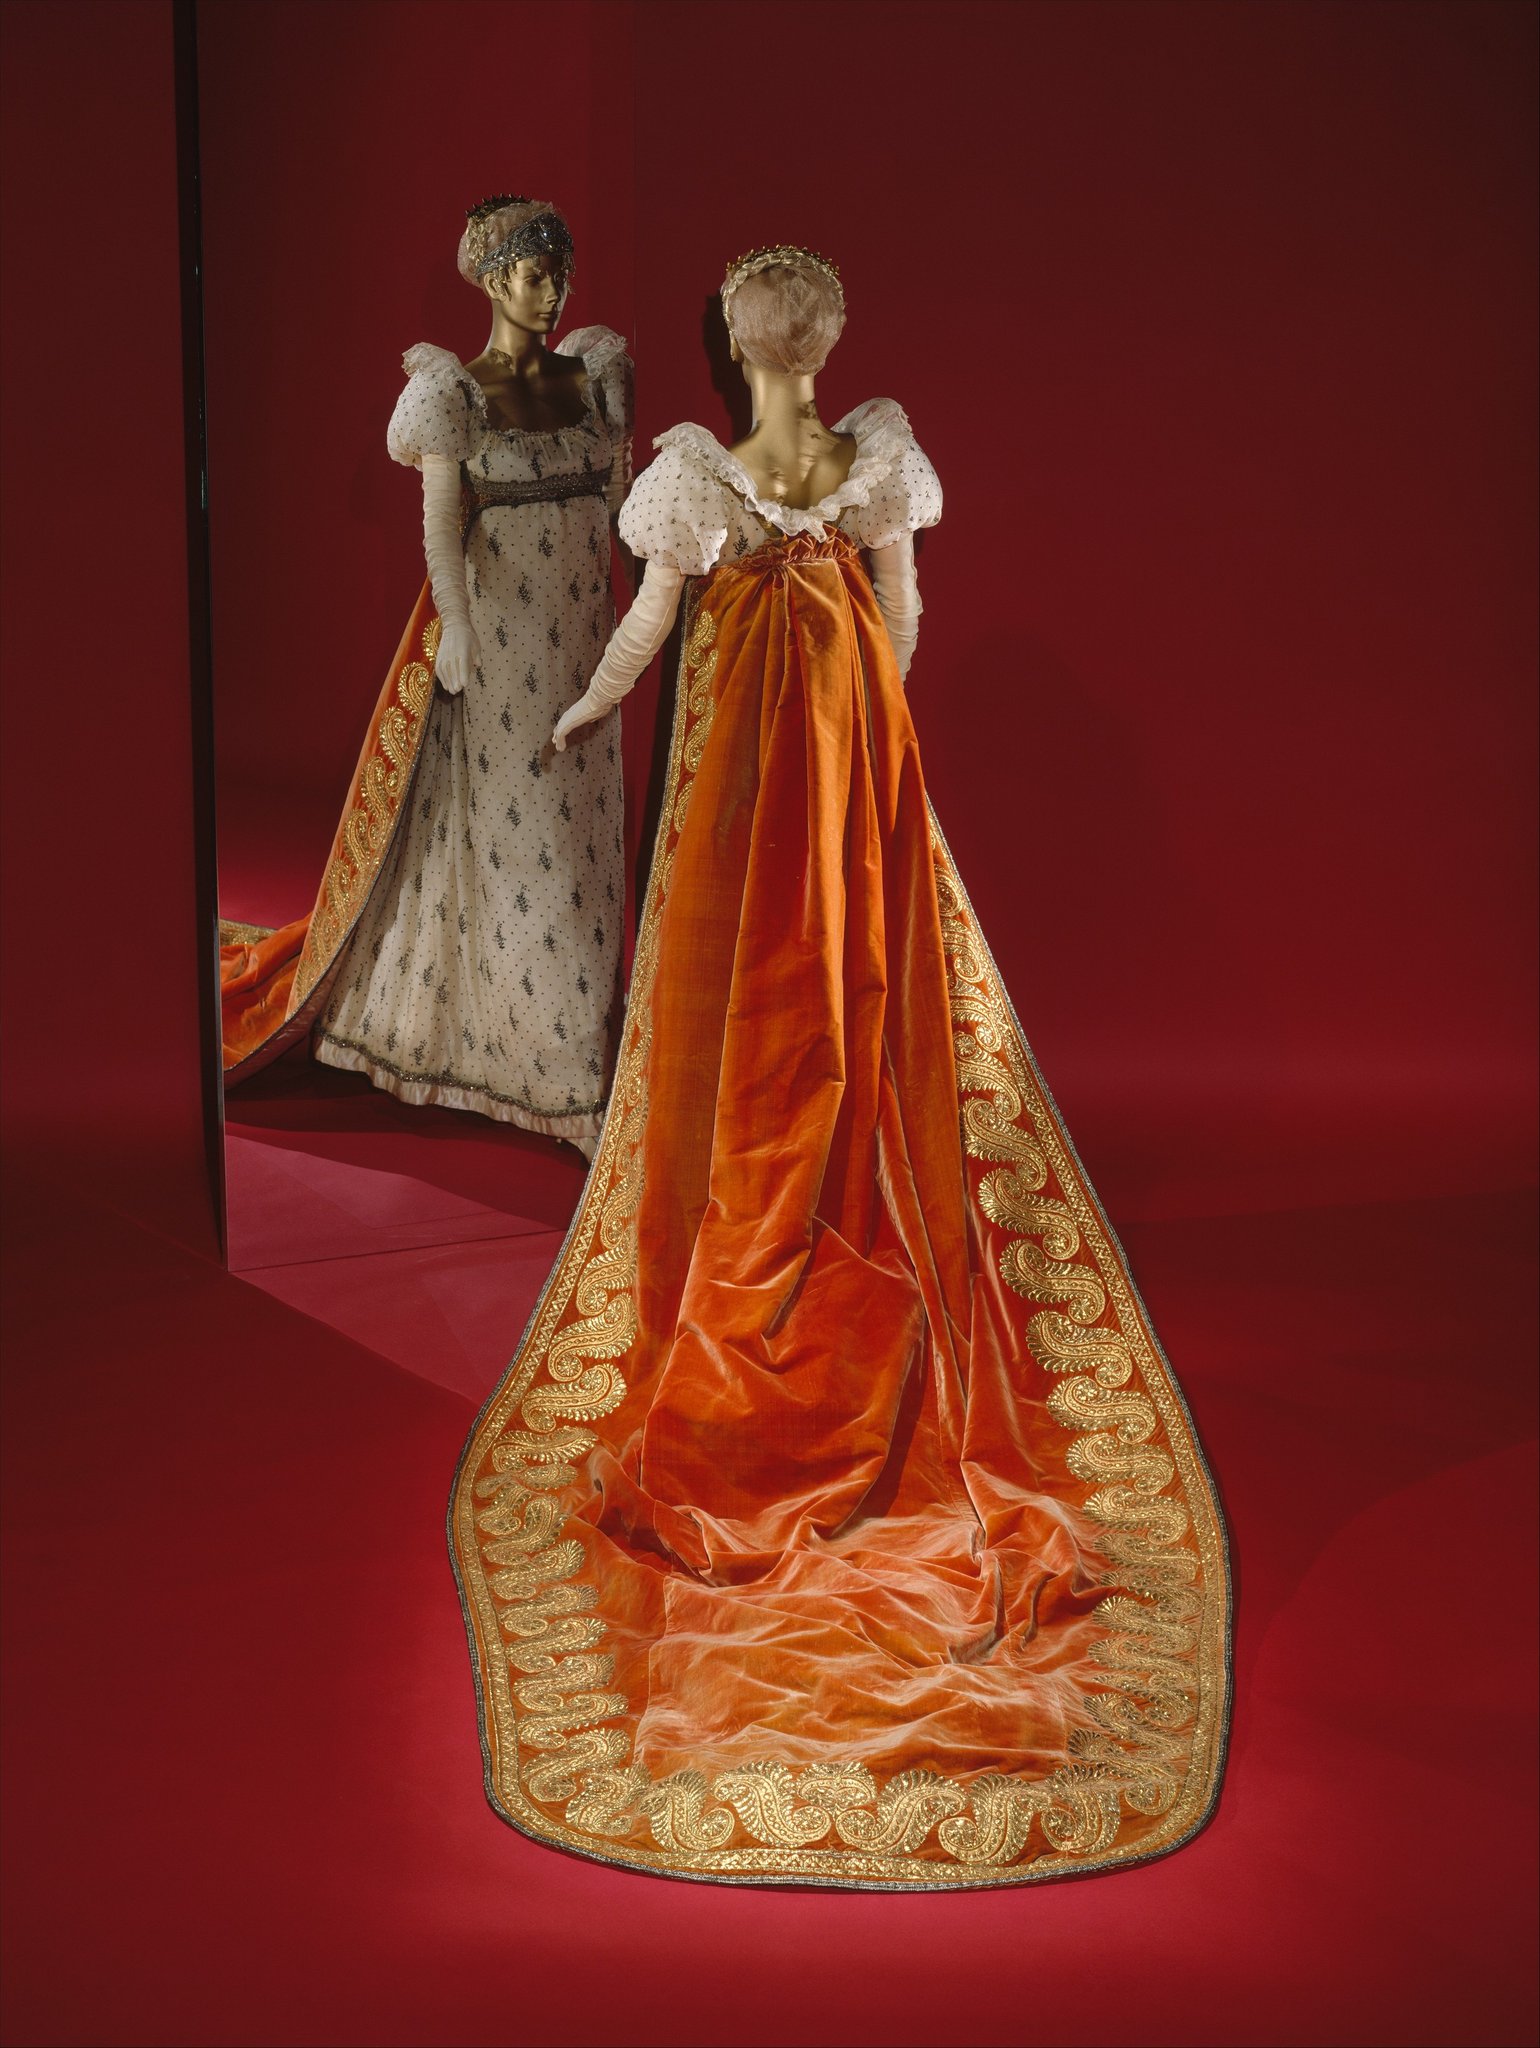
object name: court train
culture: french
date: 1809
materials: metal thread, silk